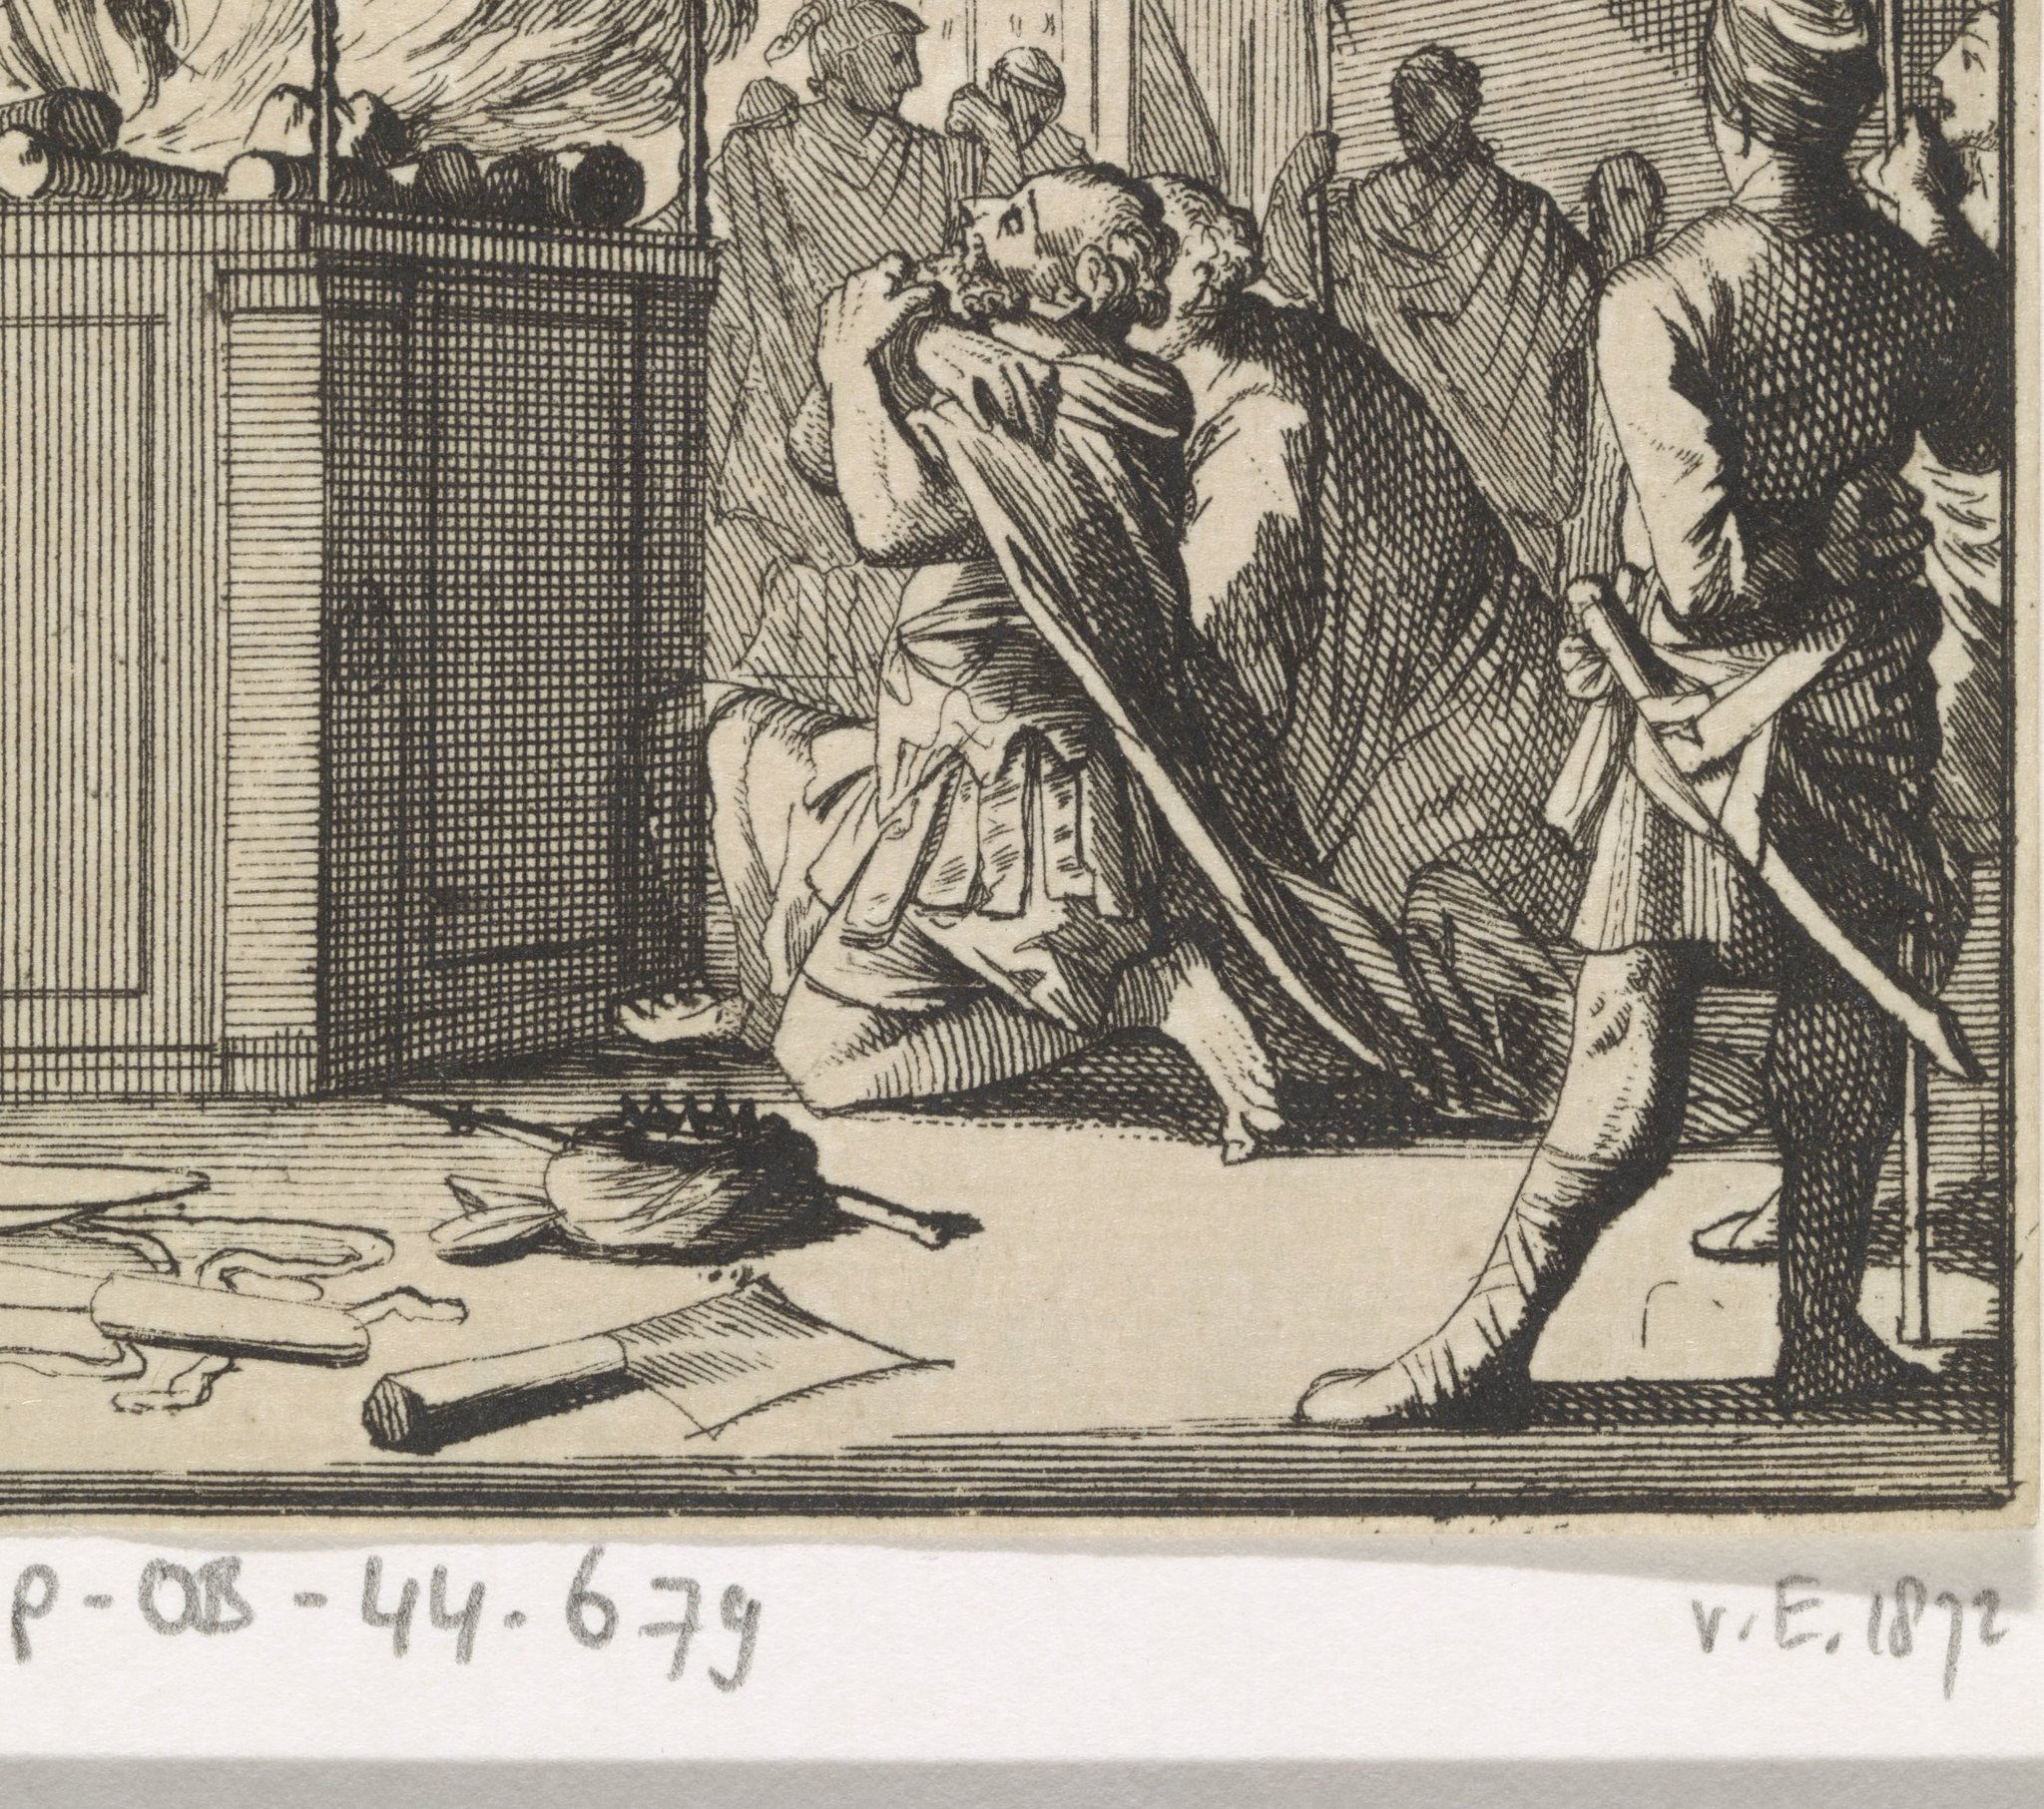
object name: print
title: Koning David knielt voor het altaar op de dorsvloer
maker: caspar luyken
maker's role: draughtsman, print maker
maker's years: 1672-1708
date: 1698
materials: paper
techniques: etching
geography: amsterdam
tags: david builds an altar in the threshing-floor of araunah and burns the offerings to god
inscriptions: collector's mark: Lugt 2228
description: Proefdruk van illustratie uit: Josephus, Flavius. XX. boeken van de oude geschiedenissen der joden, 4 delen. Amsterdam: Barent Visscher, Willem de Coup, Willem van Lamsveld, Andries van Damme, 1698, dl. I.